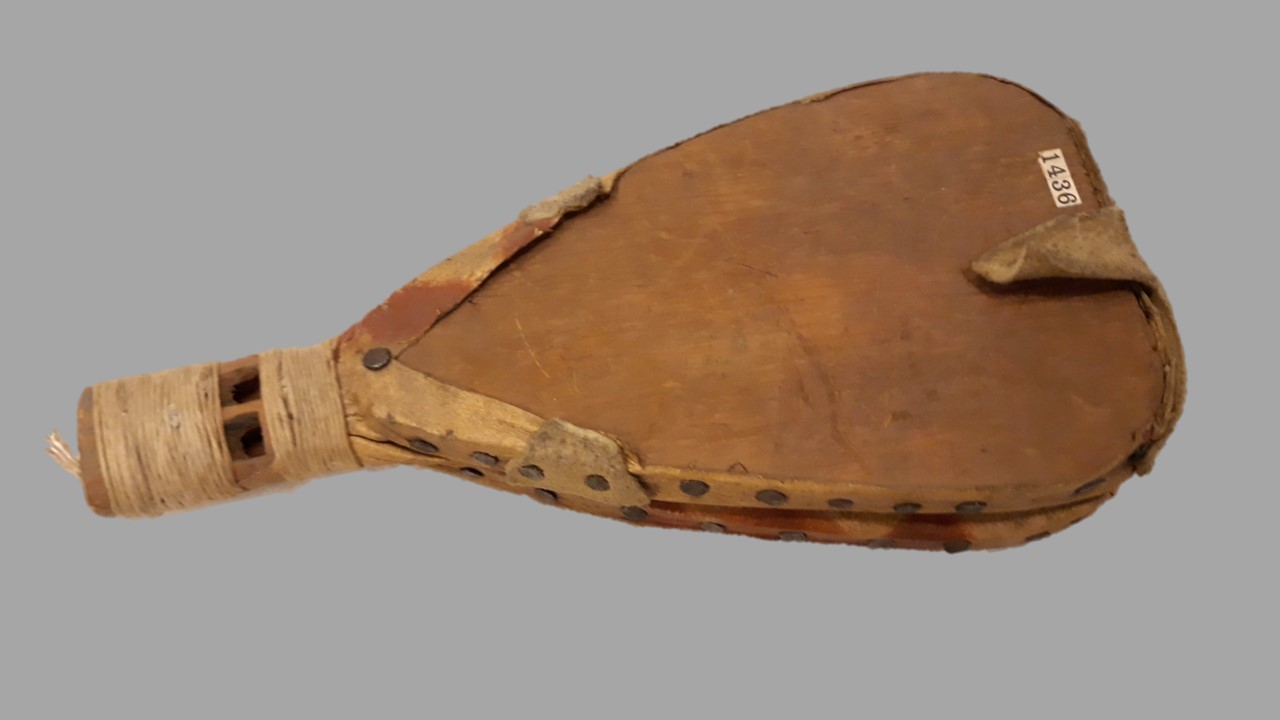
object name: stopped double pipe with bellow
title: Stopped double pipe with bellows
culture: native american, haida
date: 1801-1900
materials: cord, leather, metal, wood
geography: canada